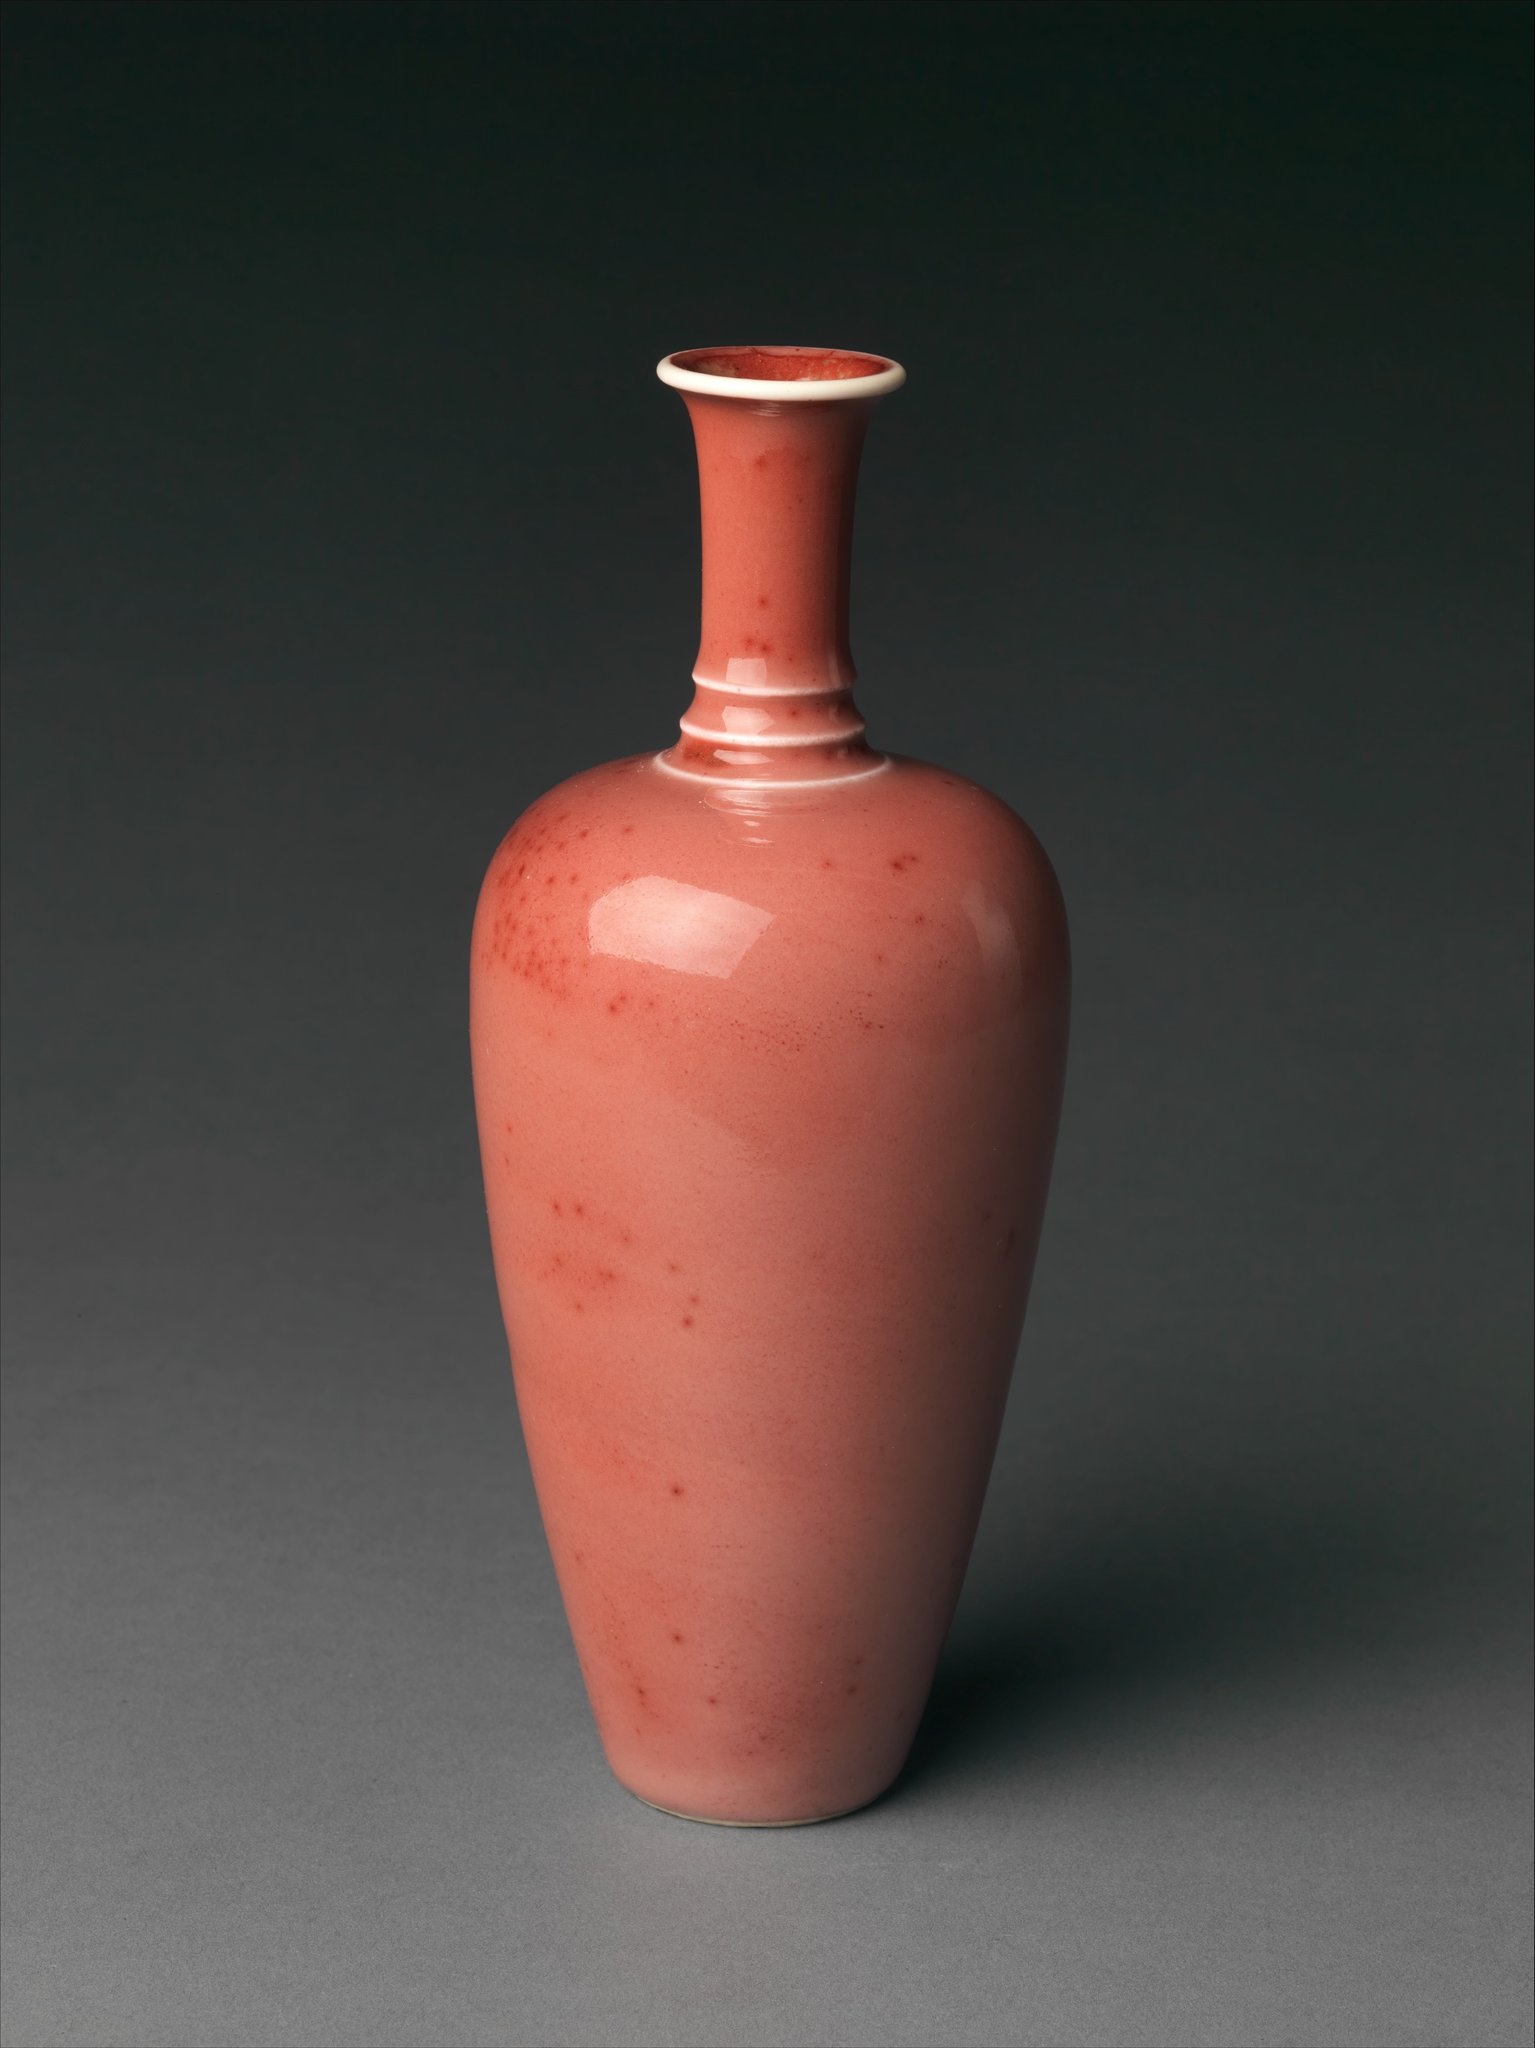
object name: vase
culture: chinese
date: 1713-1722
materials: glaze, porcelain